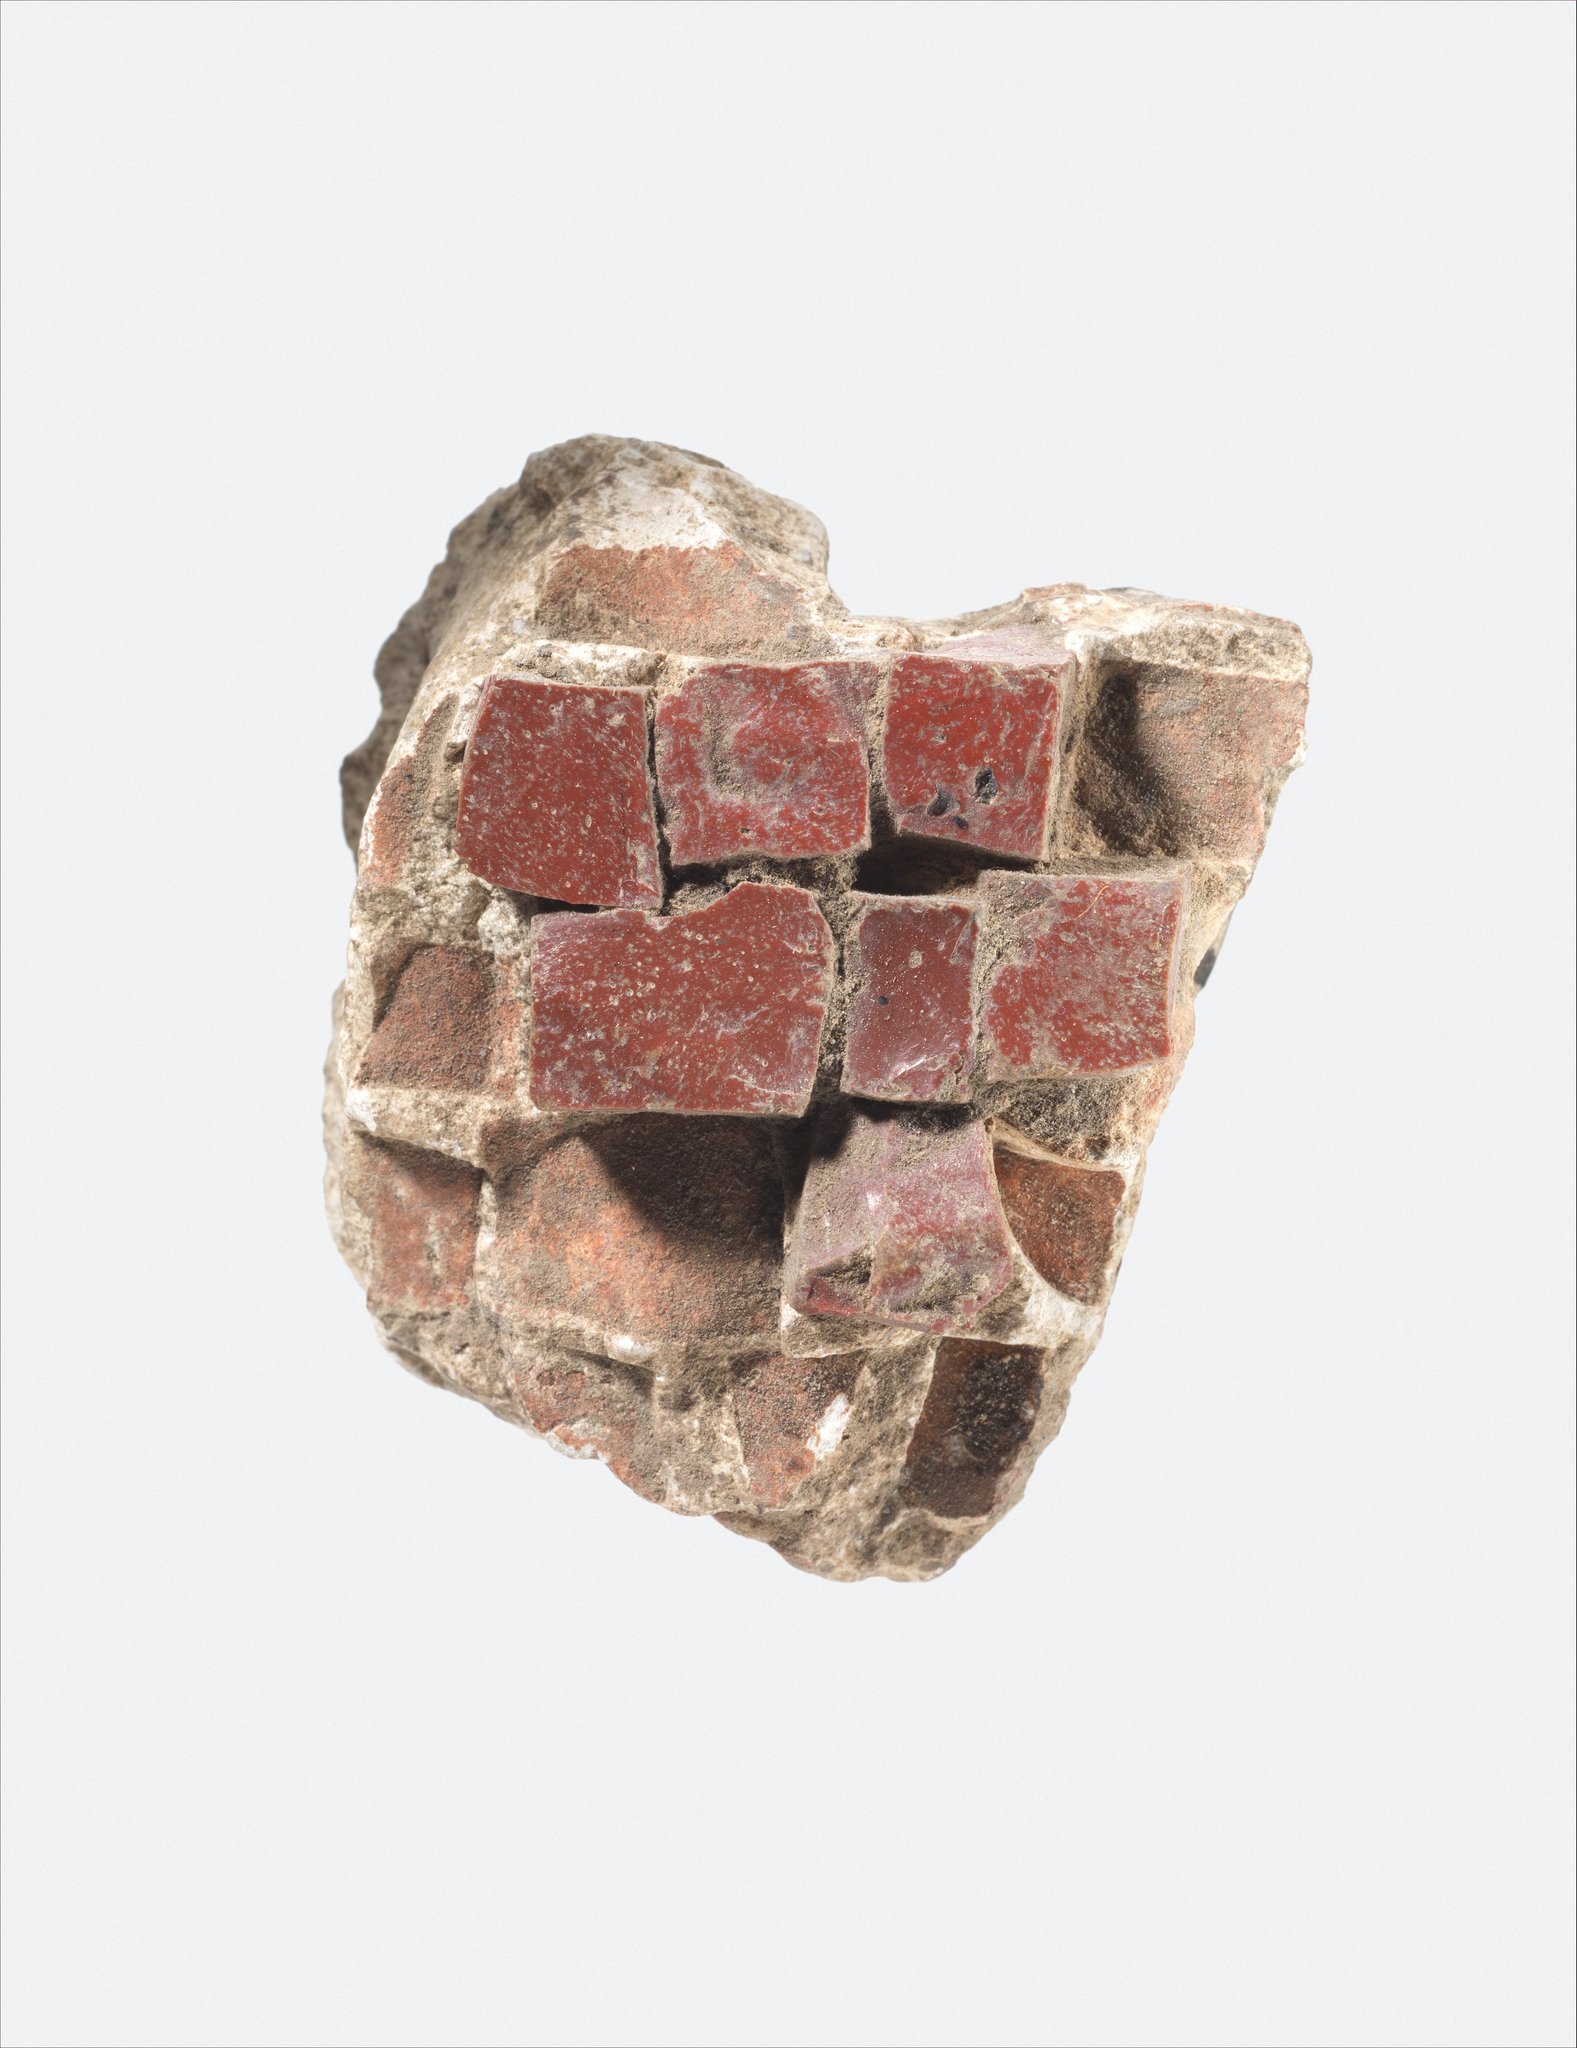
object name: mosaic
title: Mosaic fragment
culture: sasanian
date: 201-700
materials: glass, pigment, plaster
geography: mesopotamia